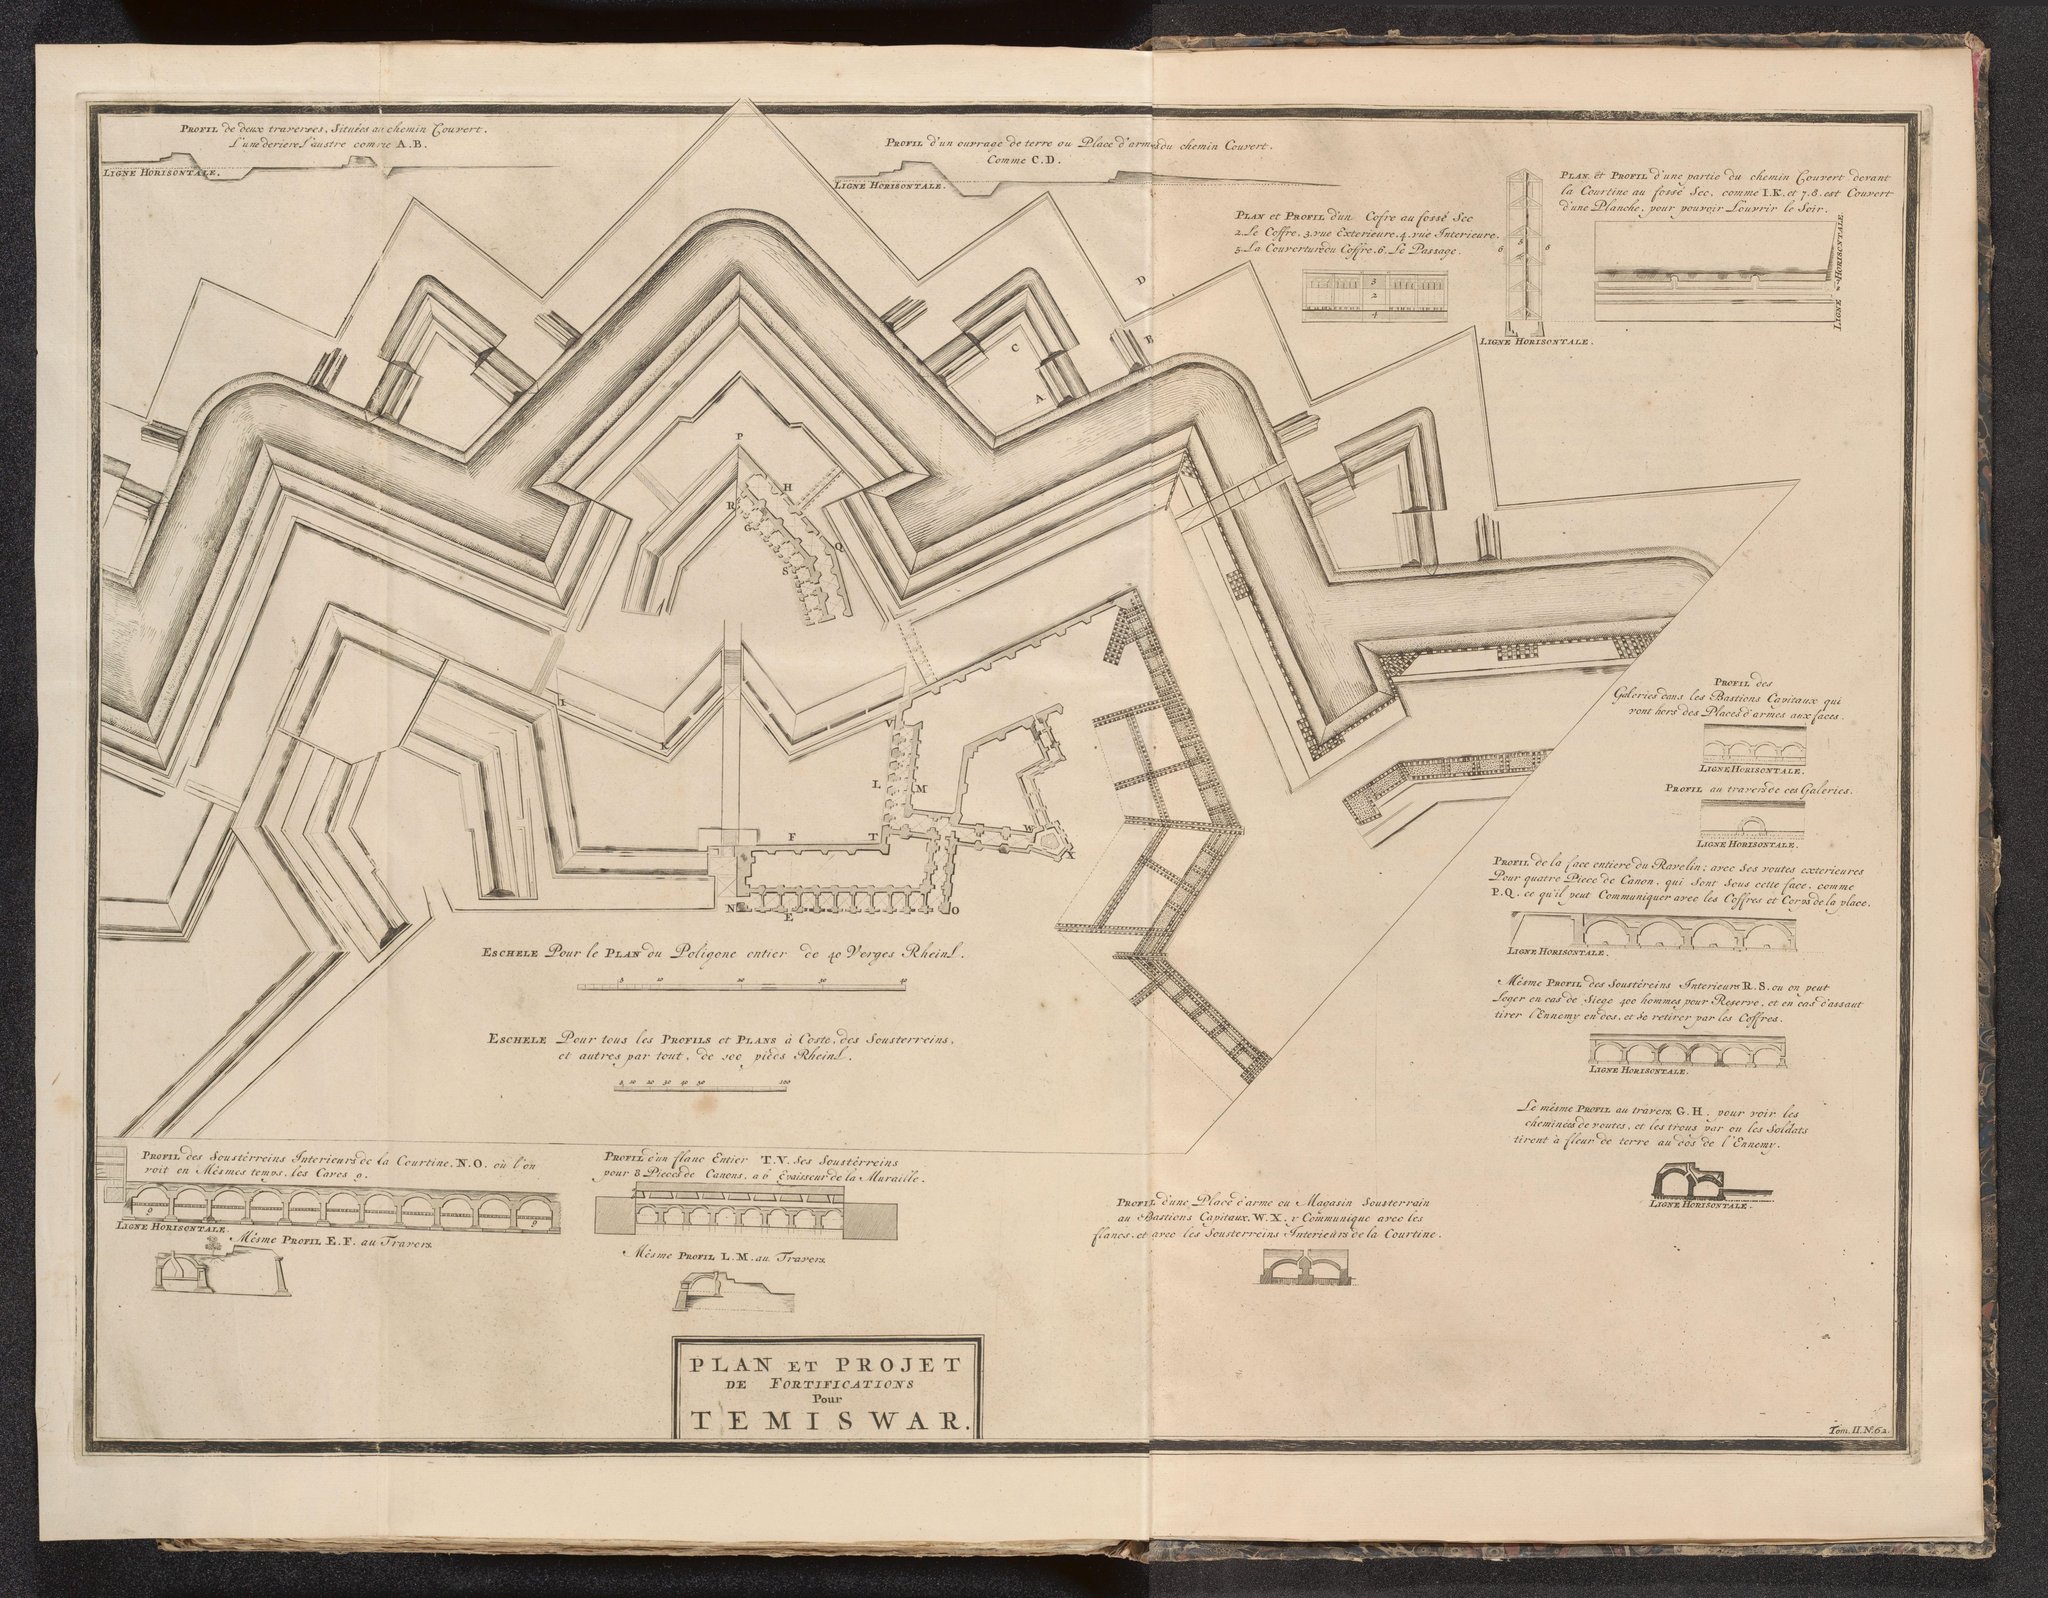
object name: print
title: Plan et Project de Fortifications Pour Temiswar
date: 1716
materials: paper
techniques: engraving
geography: northern netherlands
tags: fortress, maps of cities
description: Plattegrond van een deel van de versterkingen van Temesvár (in het huidige Roemenië), veroverd op de Turken op 13 oktober 1716. Met verschillende doorsneden. Genummerd rechtsonder: Tom. II. No. 62. Illustratie in het tweede deel van : [Jean] du Mont, Oorlogskundige beschryving van de veldslagen en belegeringen, der drie ... wydvermaarde krygsoversten... den Prins Eugenius van Savoye, den ... Hertog van Marlborough, en den Prins van Oranje en Nassau-Vriesland, in de editie van 1729. Dit tweede deel is hoofdzakelijk gewijd aan de daden van de hertog van Marlborough en prins Johan Willem Friso.